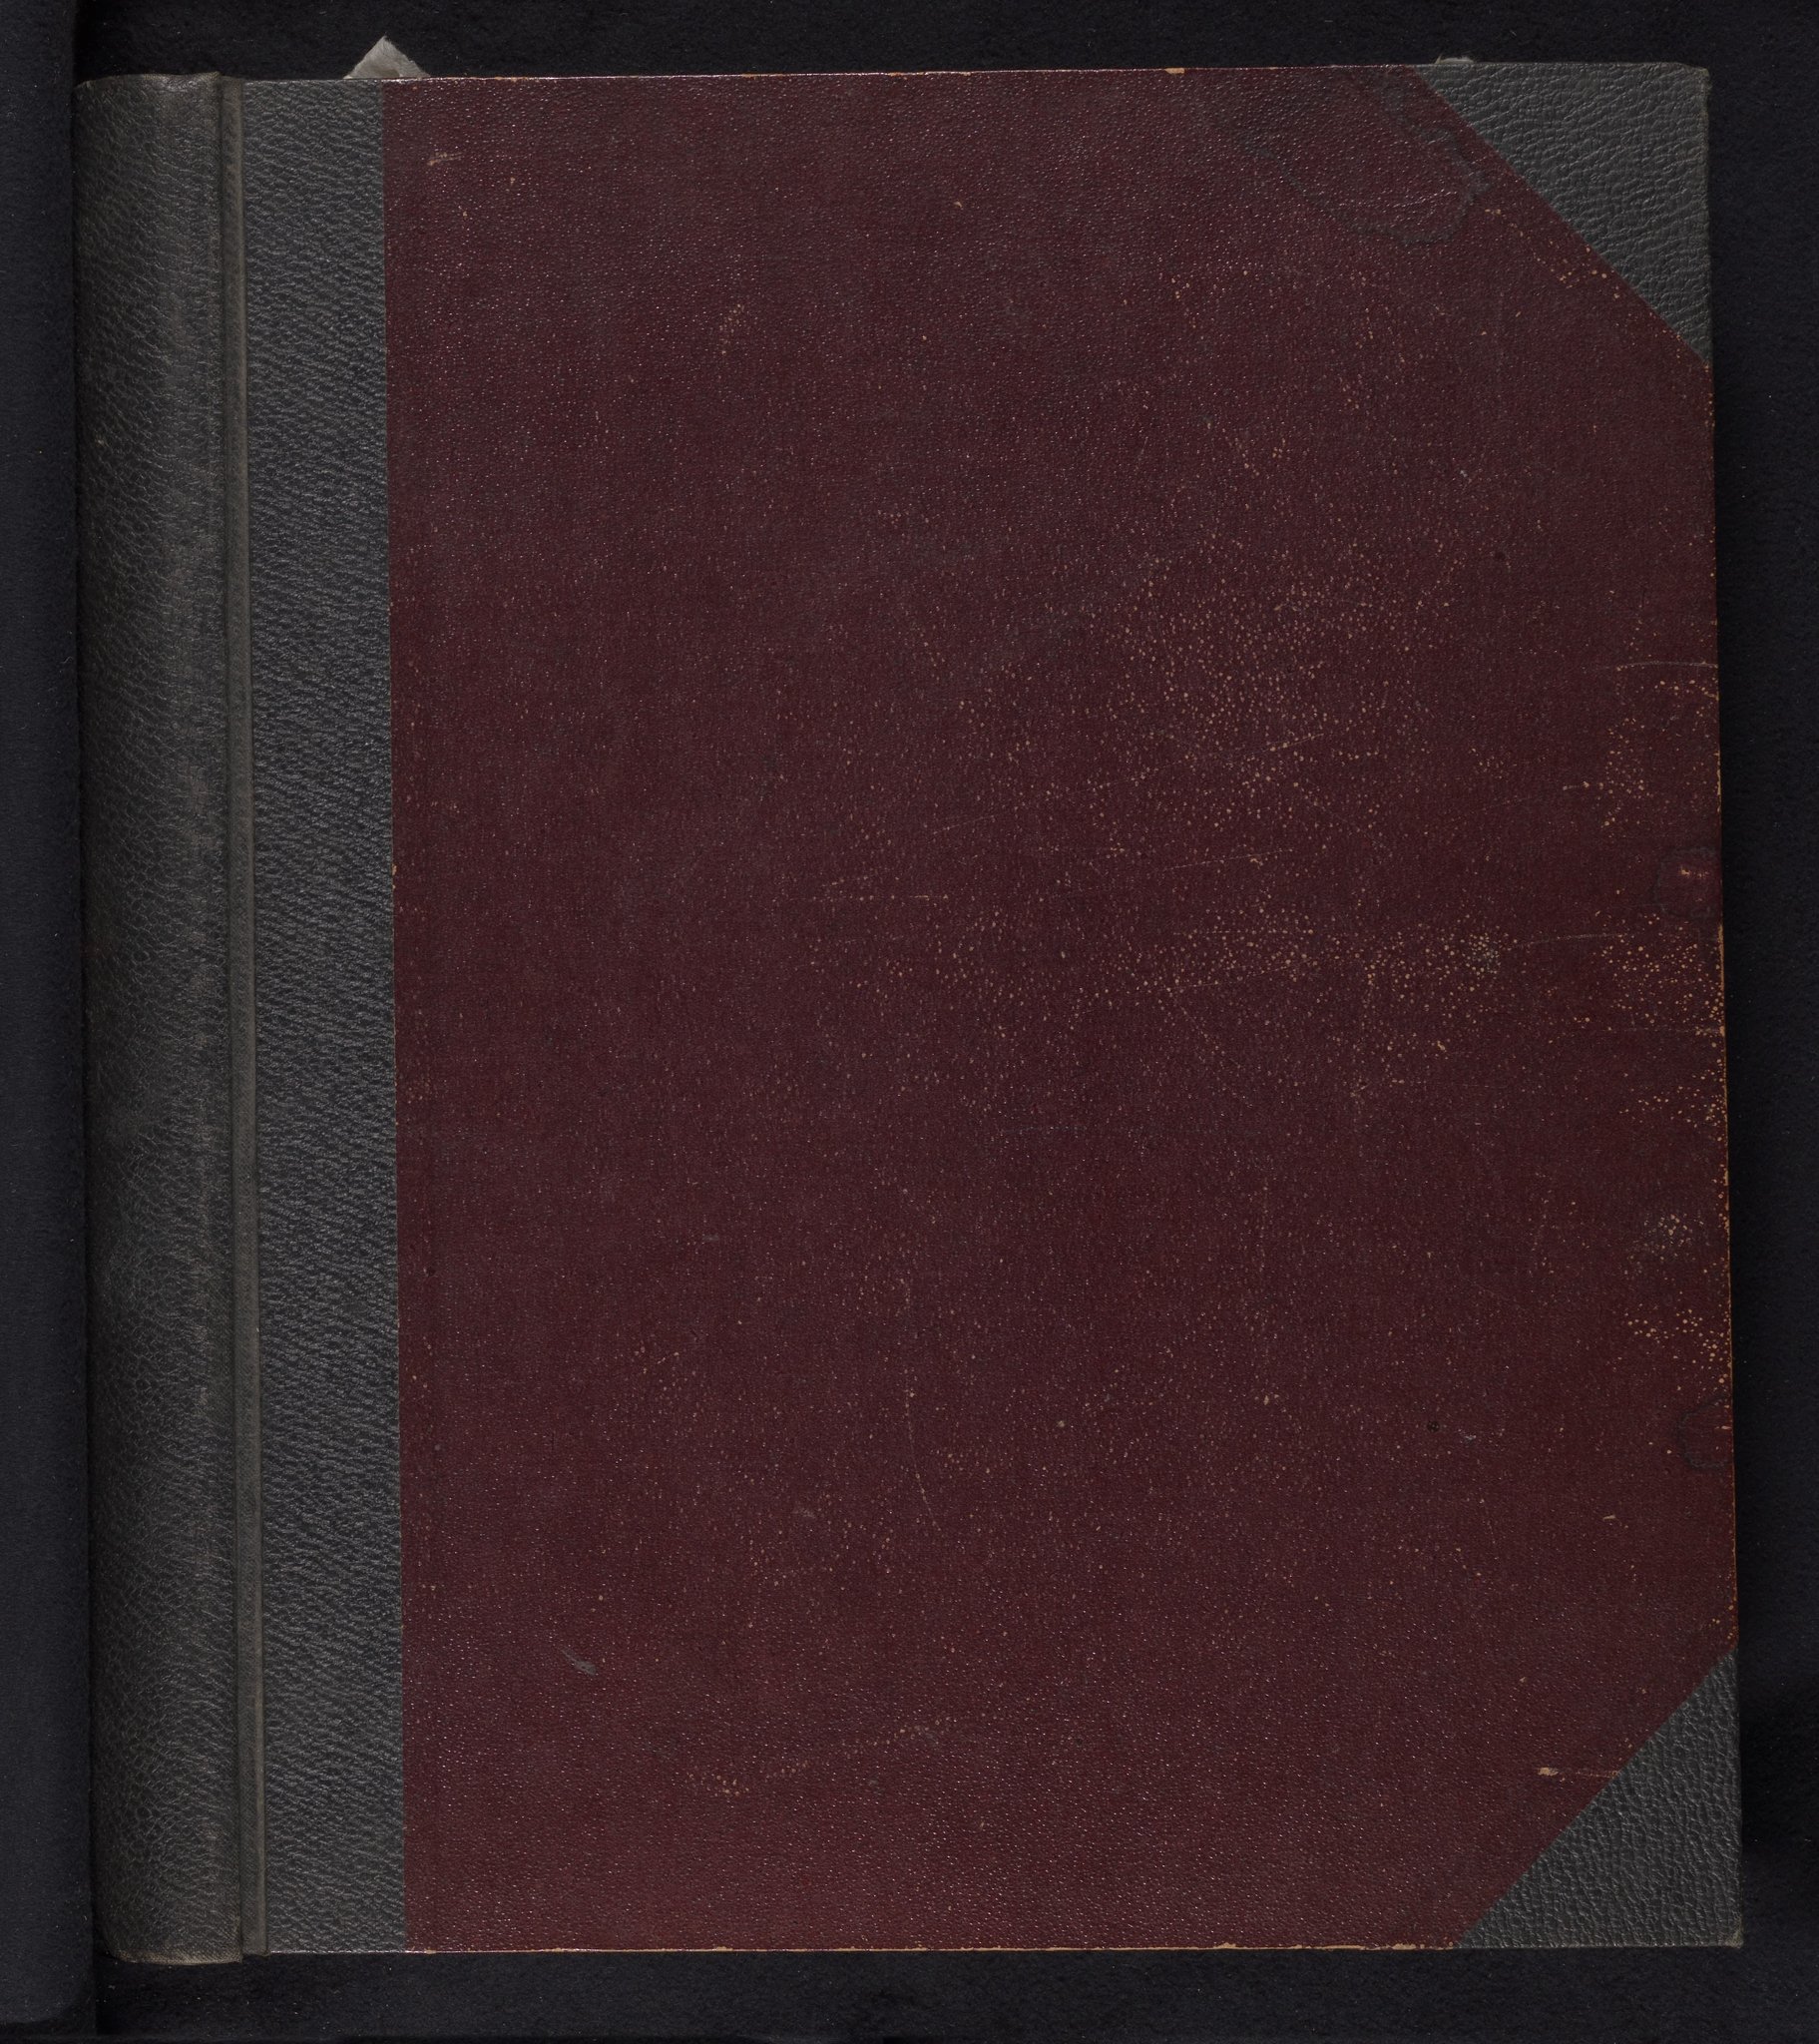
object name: album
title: Album L.J. Veen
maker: Anonymous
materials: cardboard, paper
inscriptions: number: ‘No 08898’, collector's mark: Lugt 2228a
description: Album met 88 lege bladen met op het voorste vaste schutblad een ingeplakte lijst met kunstenaarsnamen, genummerd 1 t/m 33. De nummers corresponderen met genummerde bladzijden uit het album waar illustraties ingeplakt hebben gezeten. Op de bladzijden staan annotaties die verwijzen naar publicaties waarvoor de illustraties zijn gemaakt.